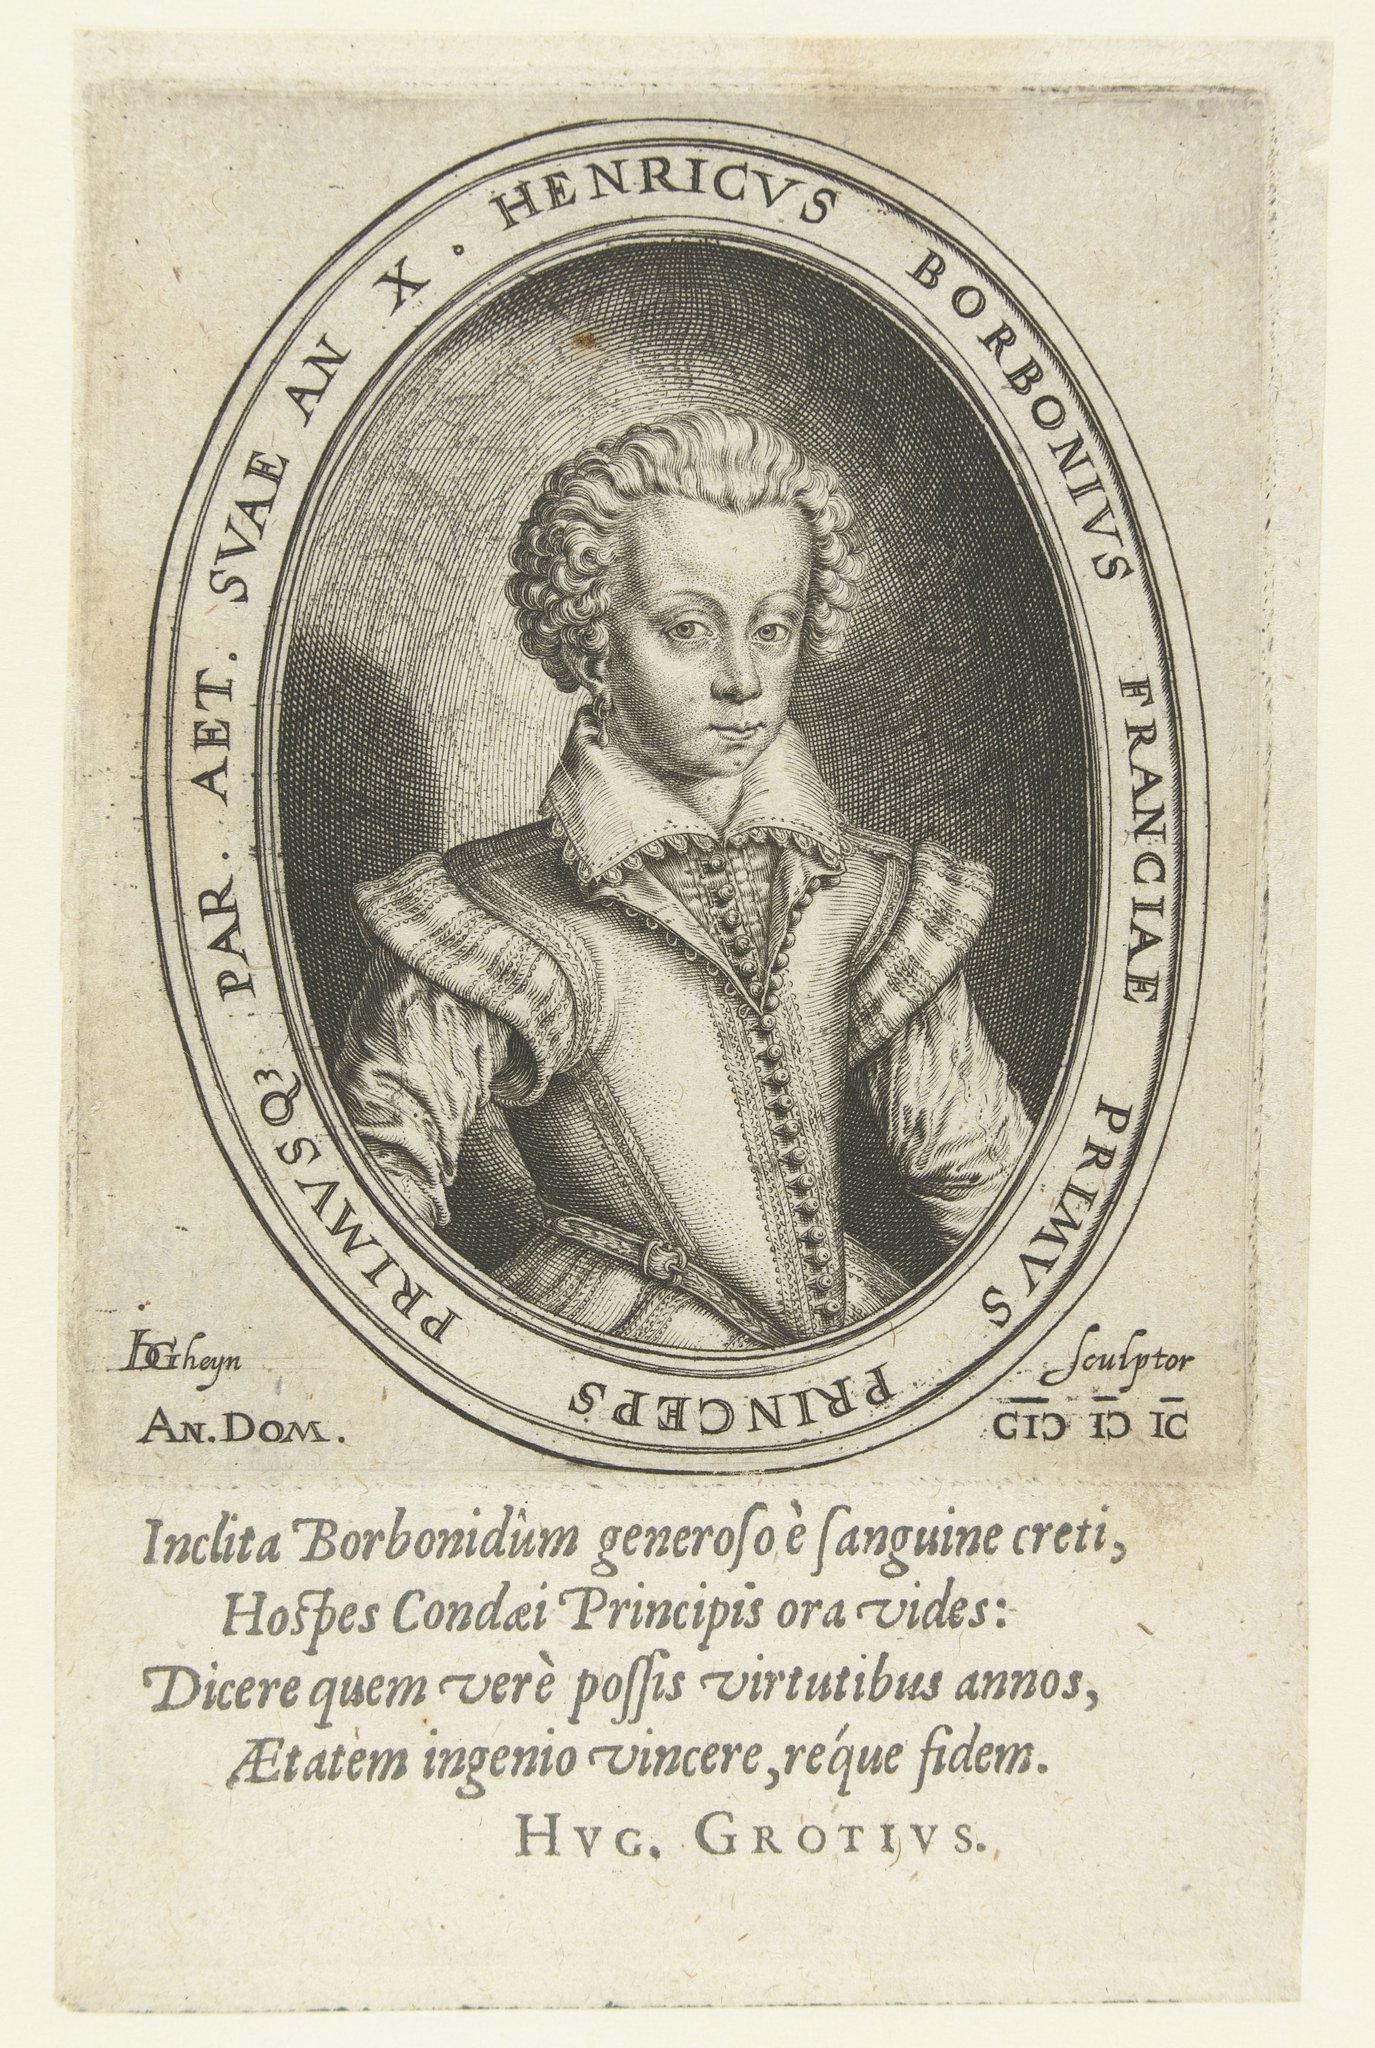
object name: print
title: Portret van Hendrik II van Bourbon, prins van Condé, op 10-jarige leeftijd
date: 1599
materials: paper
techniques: engraving, letterpress printing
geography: netherlands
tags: priest, historical persons, ear-rings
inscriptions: collector's mark: Lugt 2228a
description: Buste van Hendrik II van Bourbon-Condé (1588–1646), derde prins van Condé, op 10-jarige leeftijd, met oorbel in het rechteroor. In ovaal, met randschrift. Onder de voorstelling een vierregelig Latijns gedicht in boekdruk.